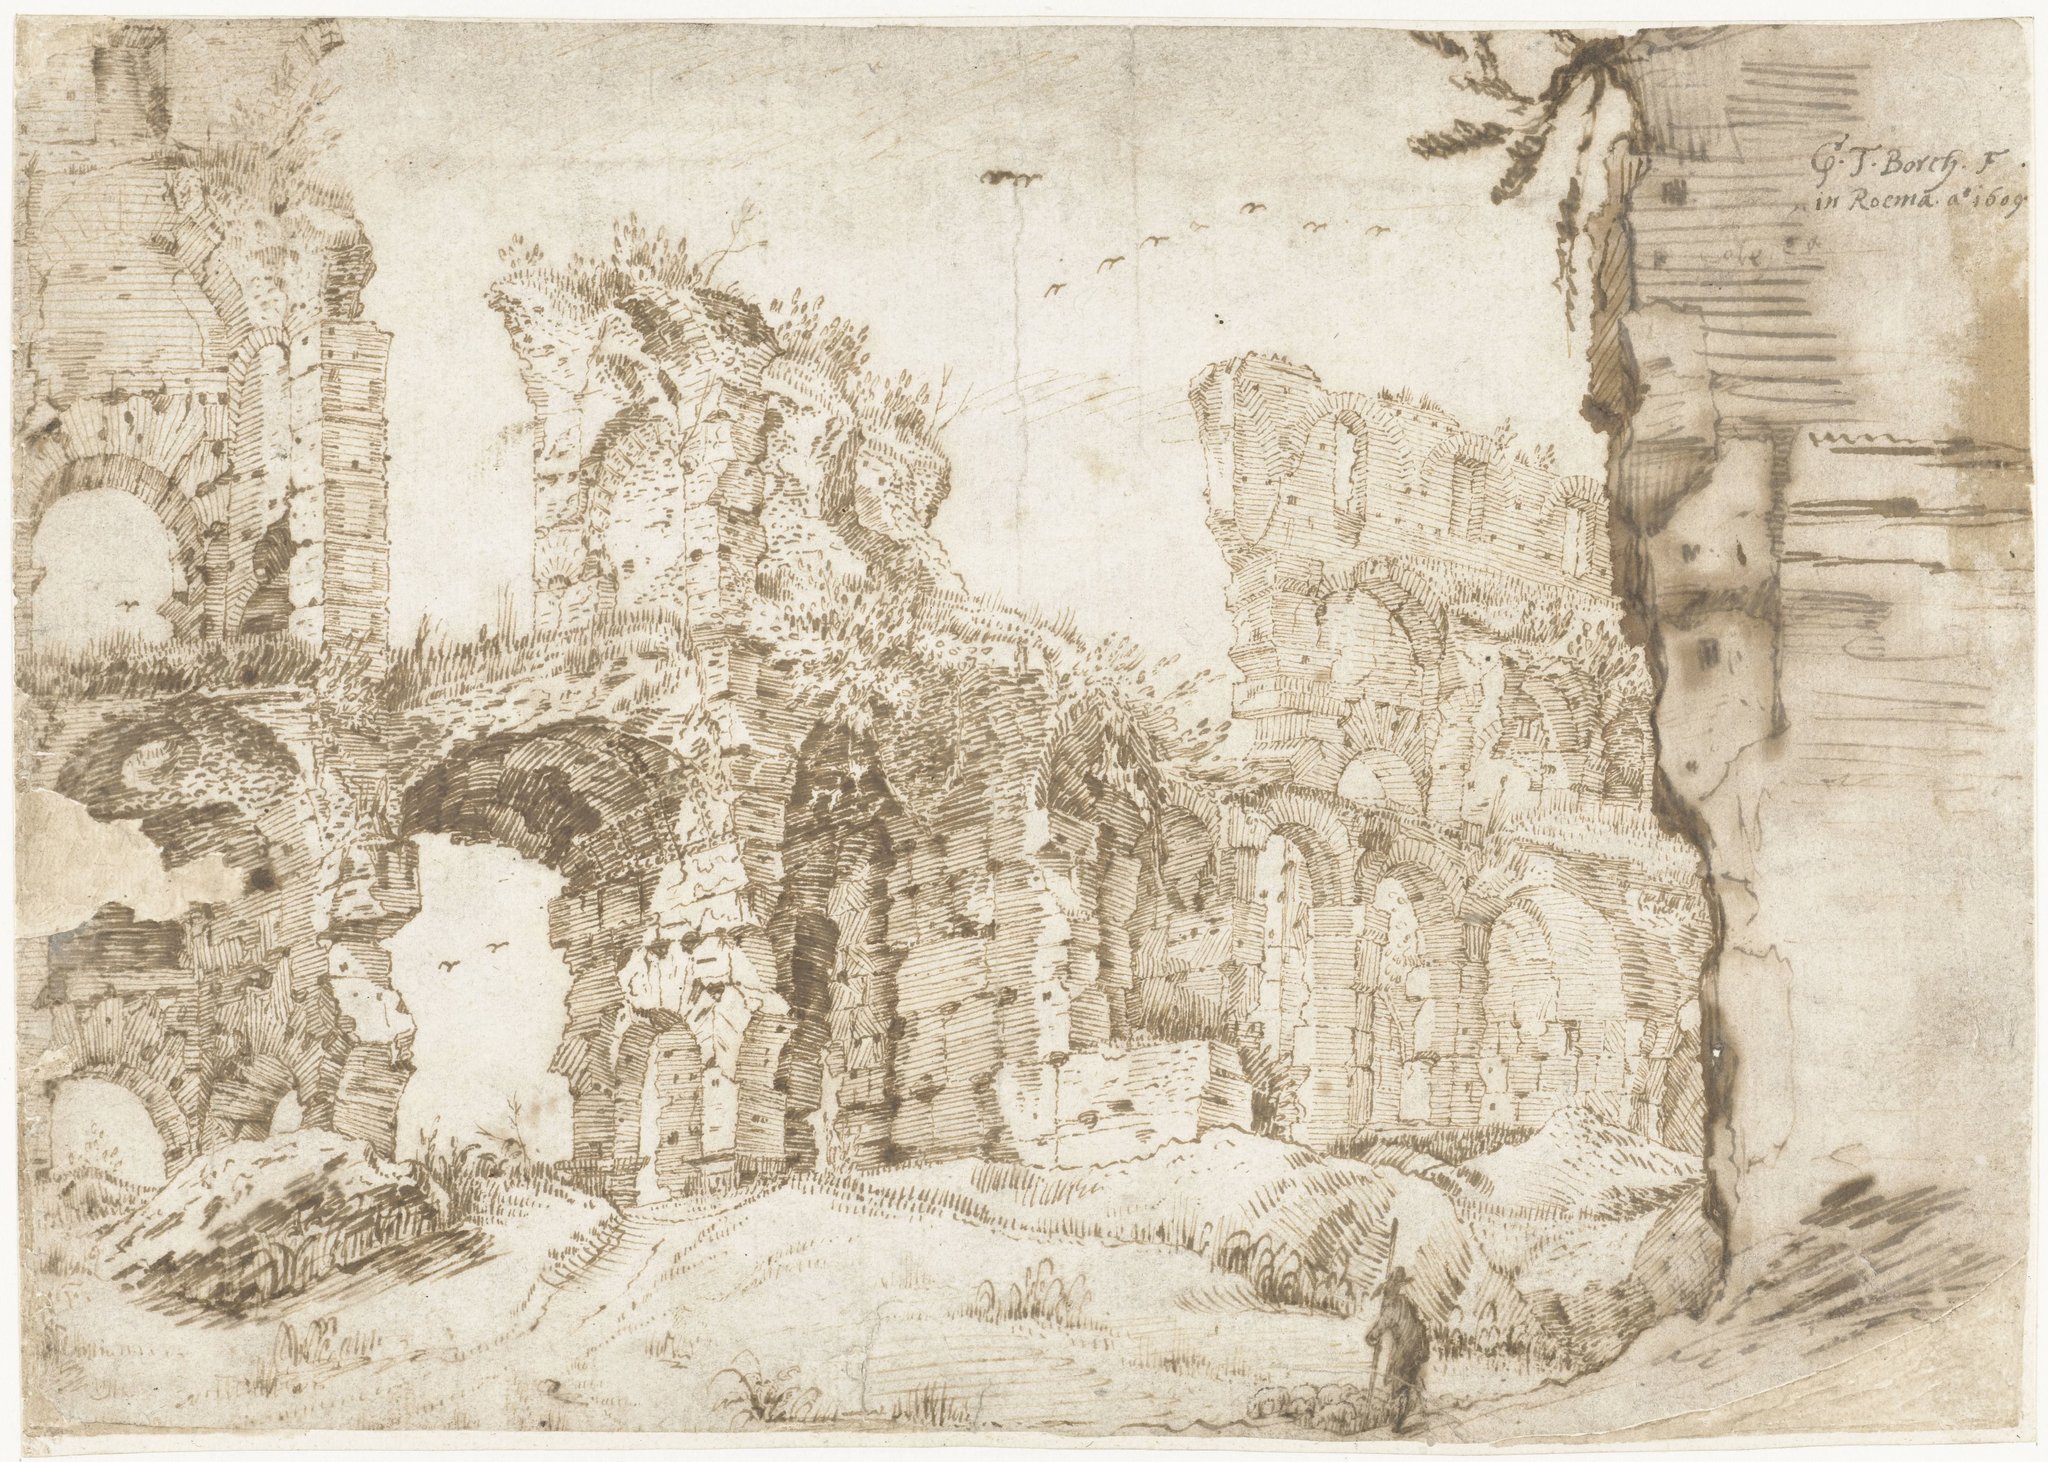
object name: drawing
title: Ruins of the Colosseum, Rome, seen from within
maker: gerard ter borch (i)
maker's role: draughtsman, print maker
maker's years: 1584-1662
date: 1609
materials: ink, paper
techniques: brush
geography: rome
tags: colosseum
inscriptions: annotation: ‘G.Ter Borch Sr.’, signature and date: ‘G.T.Borch. F. / in Roema. a° 1609’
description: Tekening uit het Romeinse schetsboek van de kunstenaar.